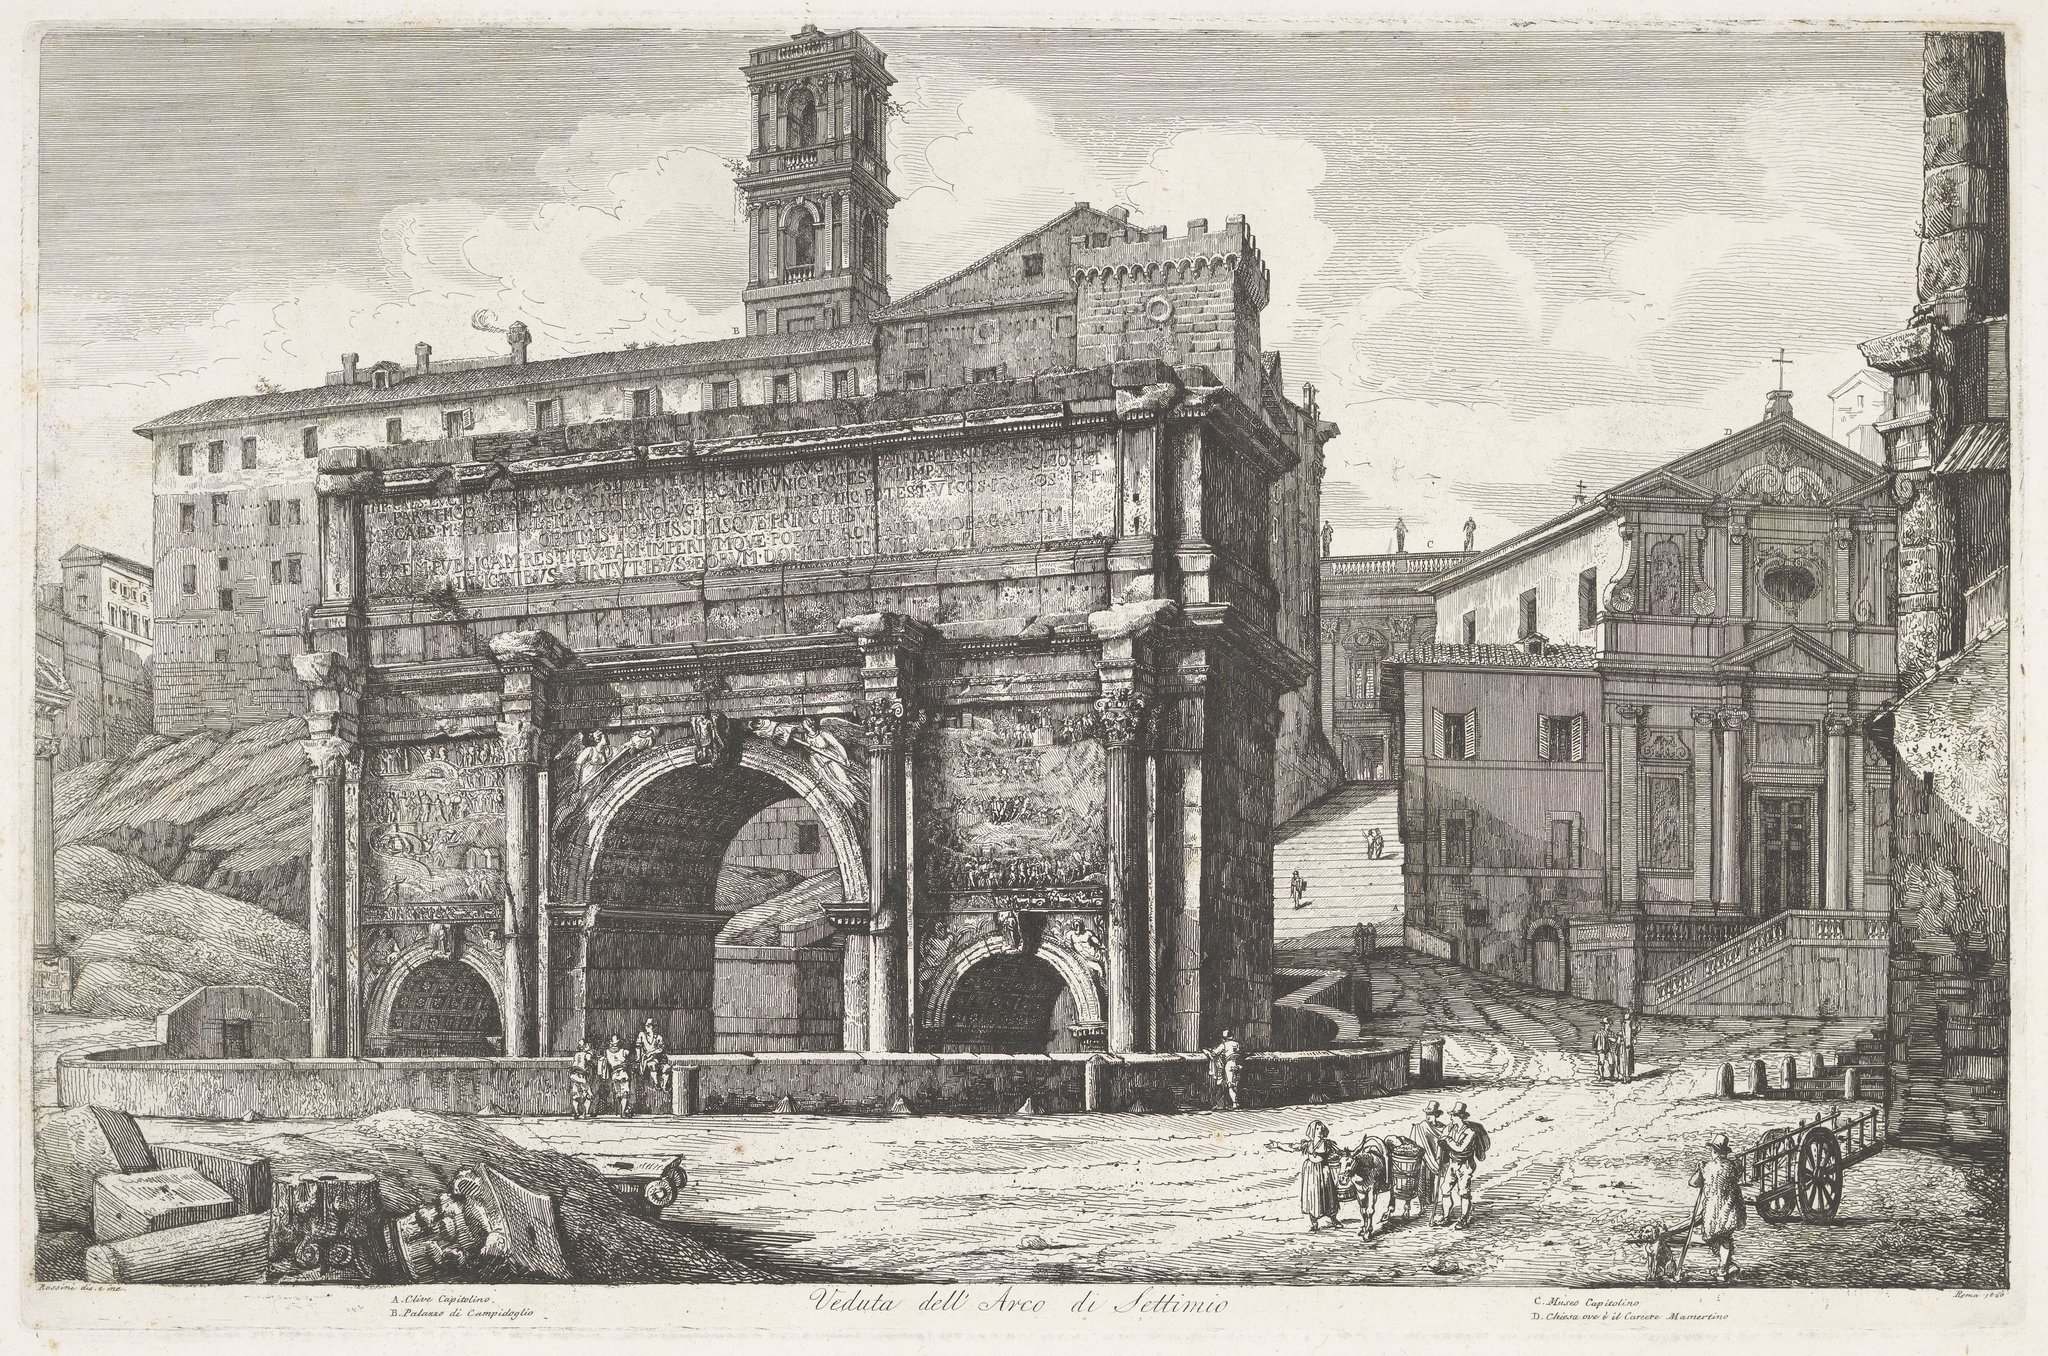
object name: print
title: Veduta dell' Arco di Settimio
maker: luigi rossini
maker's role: print maker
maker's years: 1790-1857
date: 1826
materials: paper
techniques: etching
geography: rome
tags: triumphal arch, landscape with ruins, rome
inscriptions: collector's mark: Lugt 2228, collector's mark: Lugt 2760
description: Gezicht op de Boog van Septimius Severus op het Forum Romanum te Rome. Op de achtergrond de trap richting het Capitool.